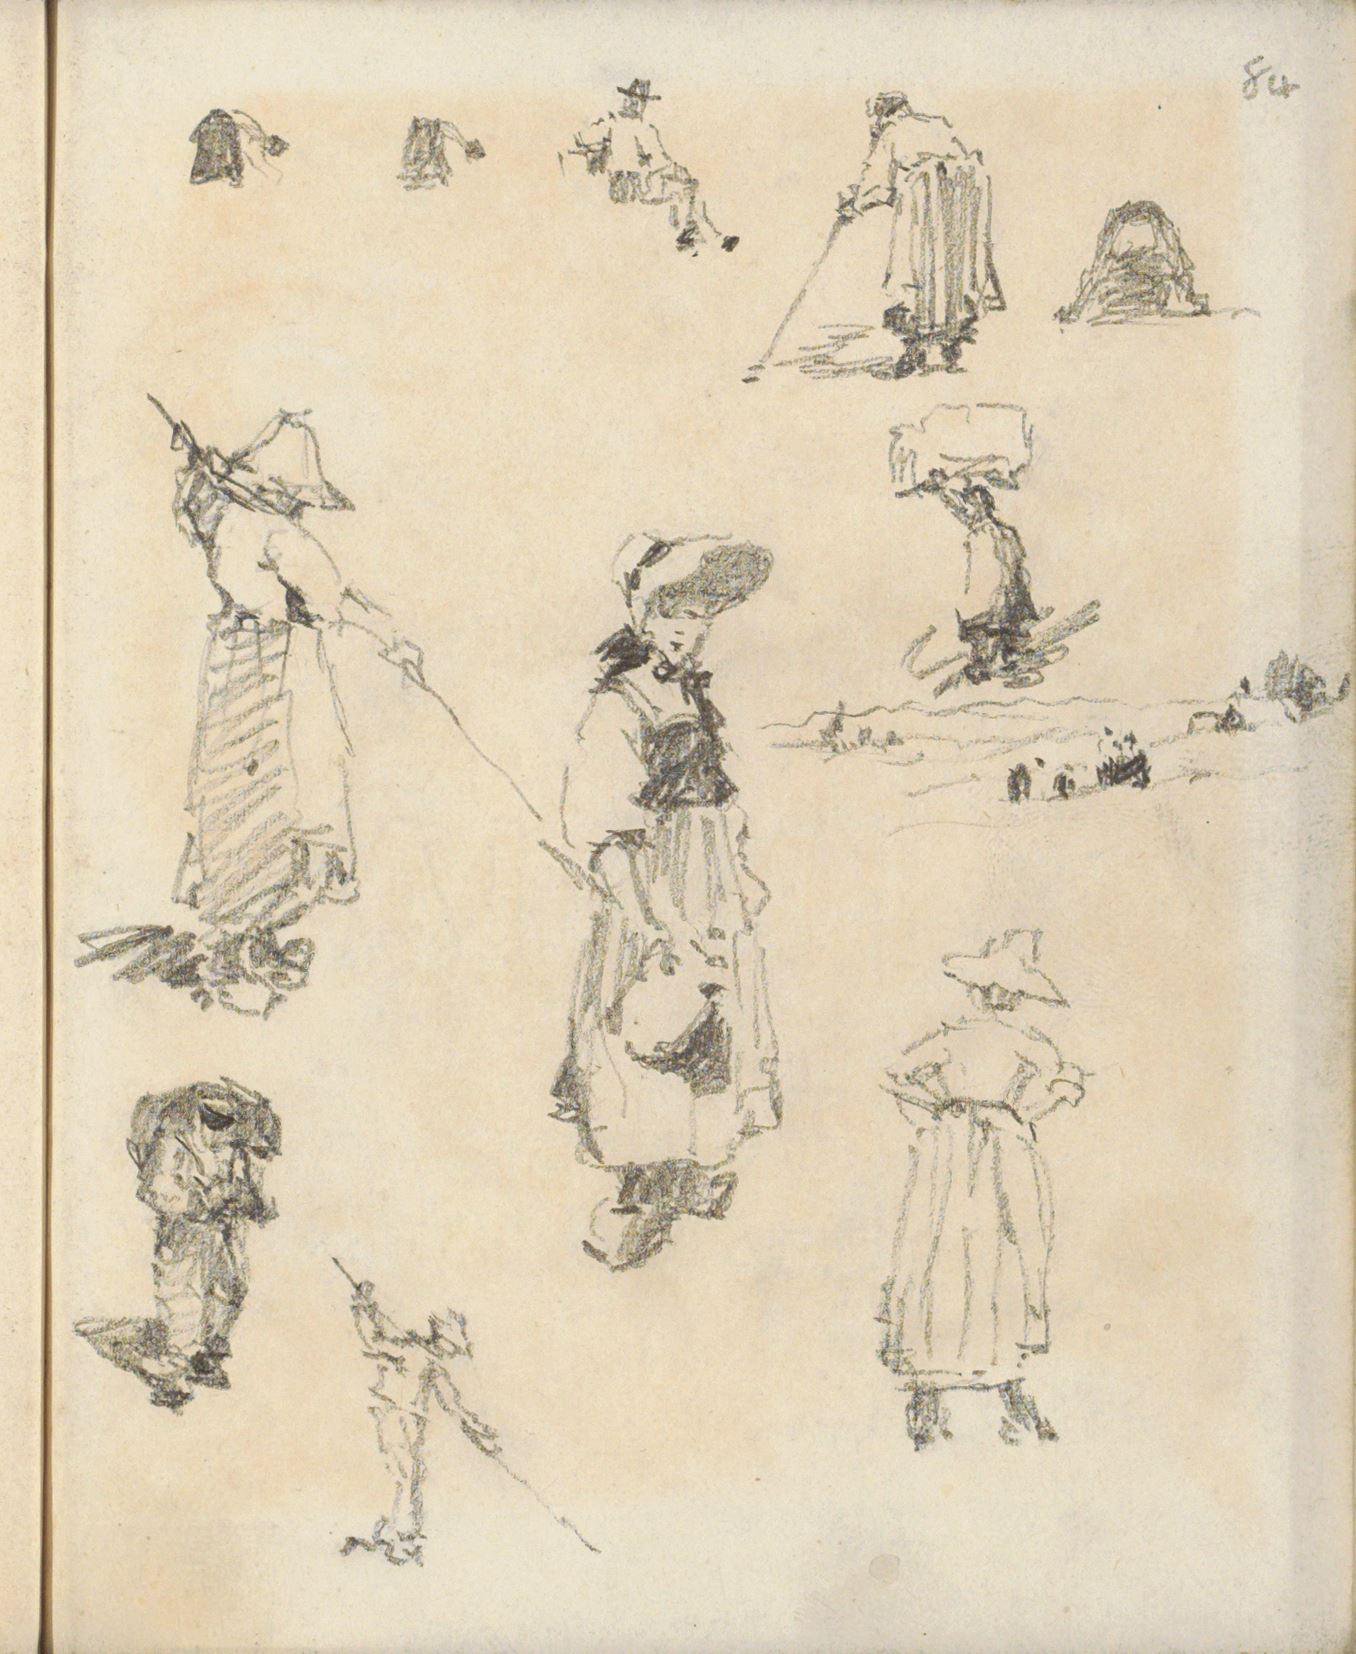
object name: sketchbook leaf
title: Figuren, onder andere aardappelrooiers en landarbeiders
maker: alfred william rich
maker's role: draughtsman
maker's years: 1856-1921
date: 1892-1893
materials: paper, pencil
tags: plants cultivated for their edible roots or tubers, e.g. potato, turnip (labourers ~ crafts, industries, agriculture)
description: Blad 84 recto uit een schetsboek met 86 bladen.